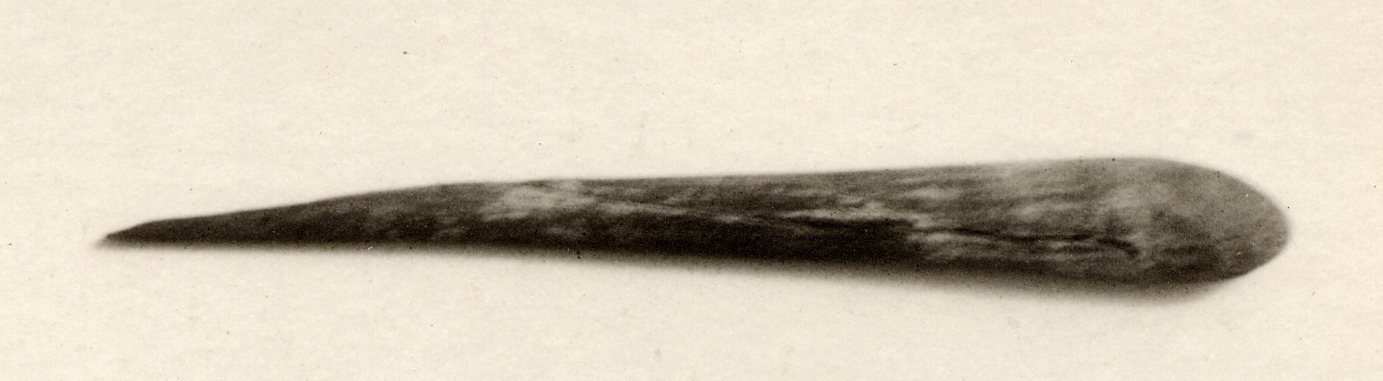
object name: kohl stick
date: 1635-1458 BCE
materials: wood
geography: egypt